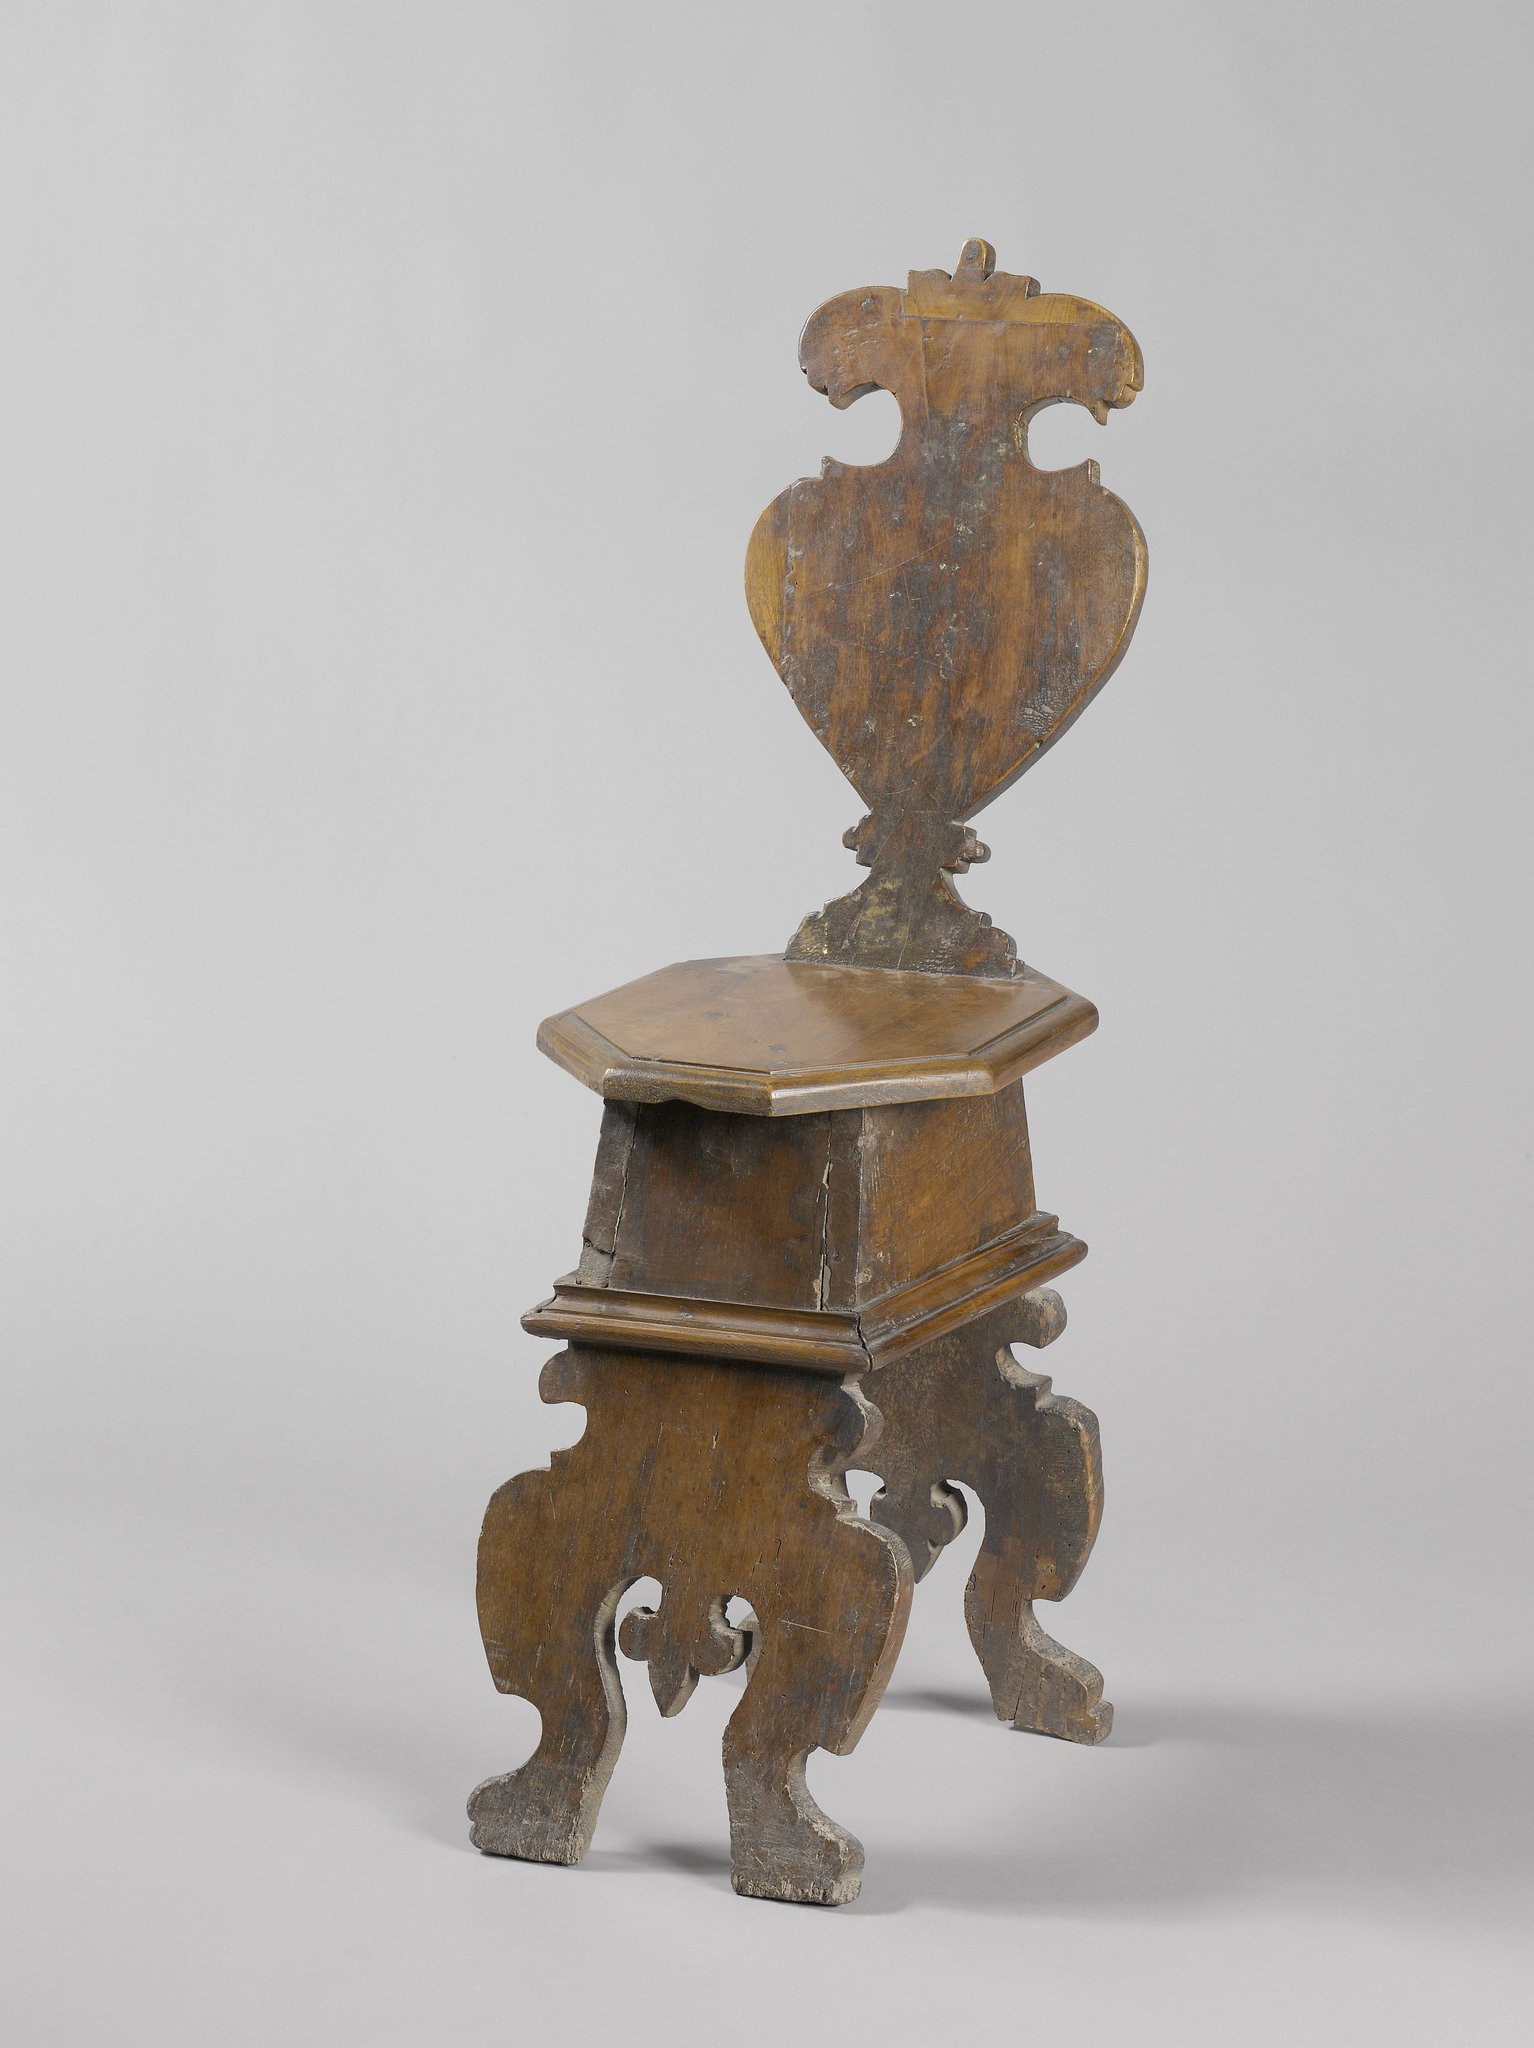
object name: furniture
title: Sgabello, stoel van notenhout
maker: Anonymous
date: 1500-1600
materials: wood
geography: italy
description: Sgabello van notenhout rustend op een voor- en achterpoot in de vorm van twee vlak uiteengezette klauwpoten, waartussen een hangende, gestileerde lelie. Door een geprofileerde lijst zijn achter- en voorbord gescheiden van de brede zitregels; de zeshoekige zitting steekt over. De vlakke rug is vaasvormig uitgezaagd. Zie tevens: BK-15384 en BK-15385.